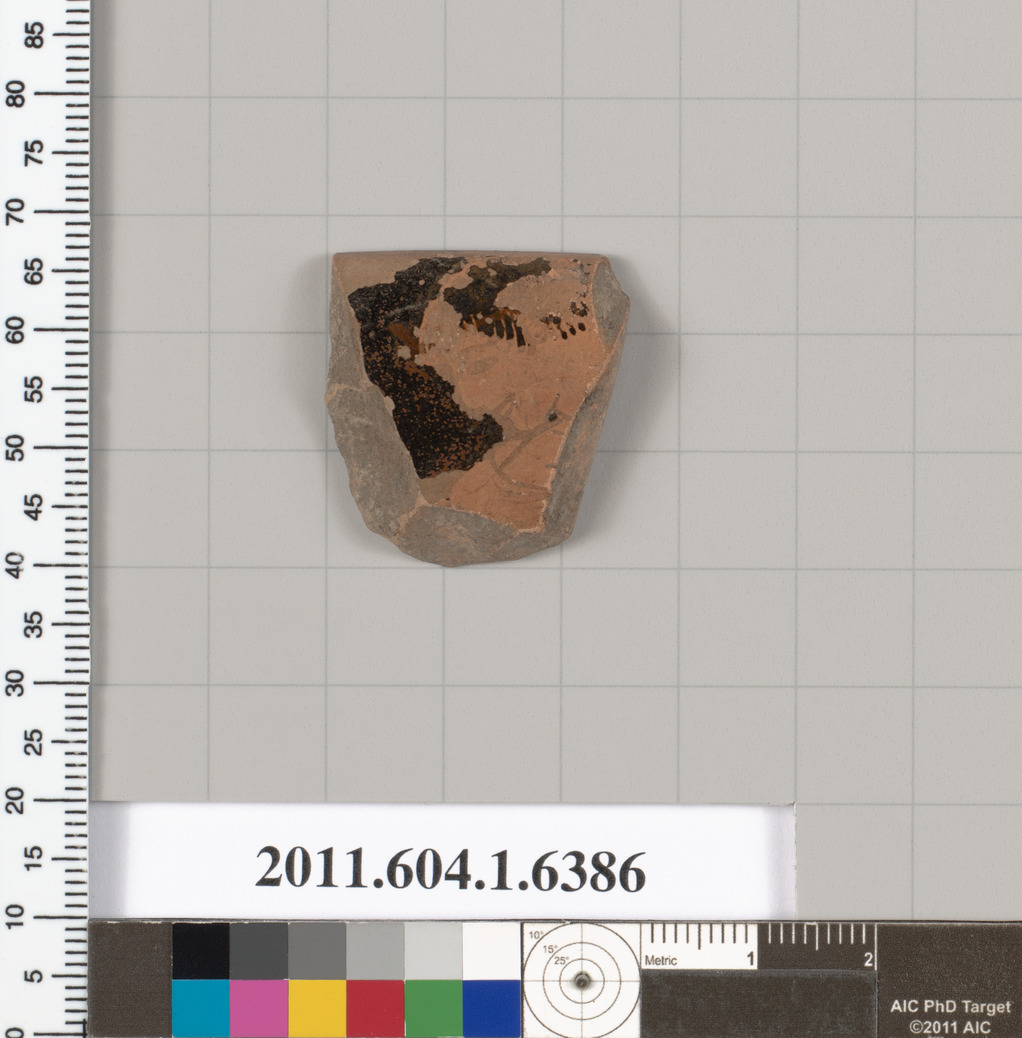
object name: kylix fragment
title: Terracotta rim fragment of a kylix (drinking cup)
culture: greek, attic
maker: antiphon painter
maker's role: artist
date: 490-480 BCE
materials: terracotta